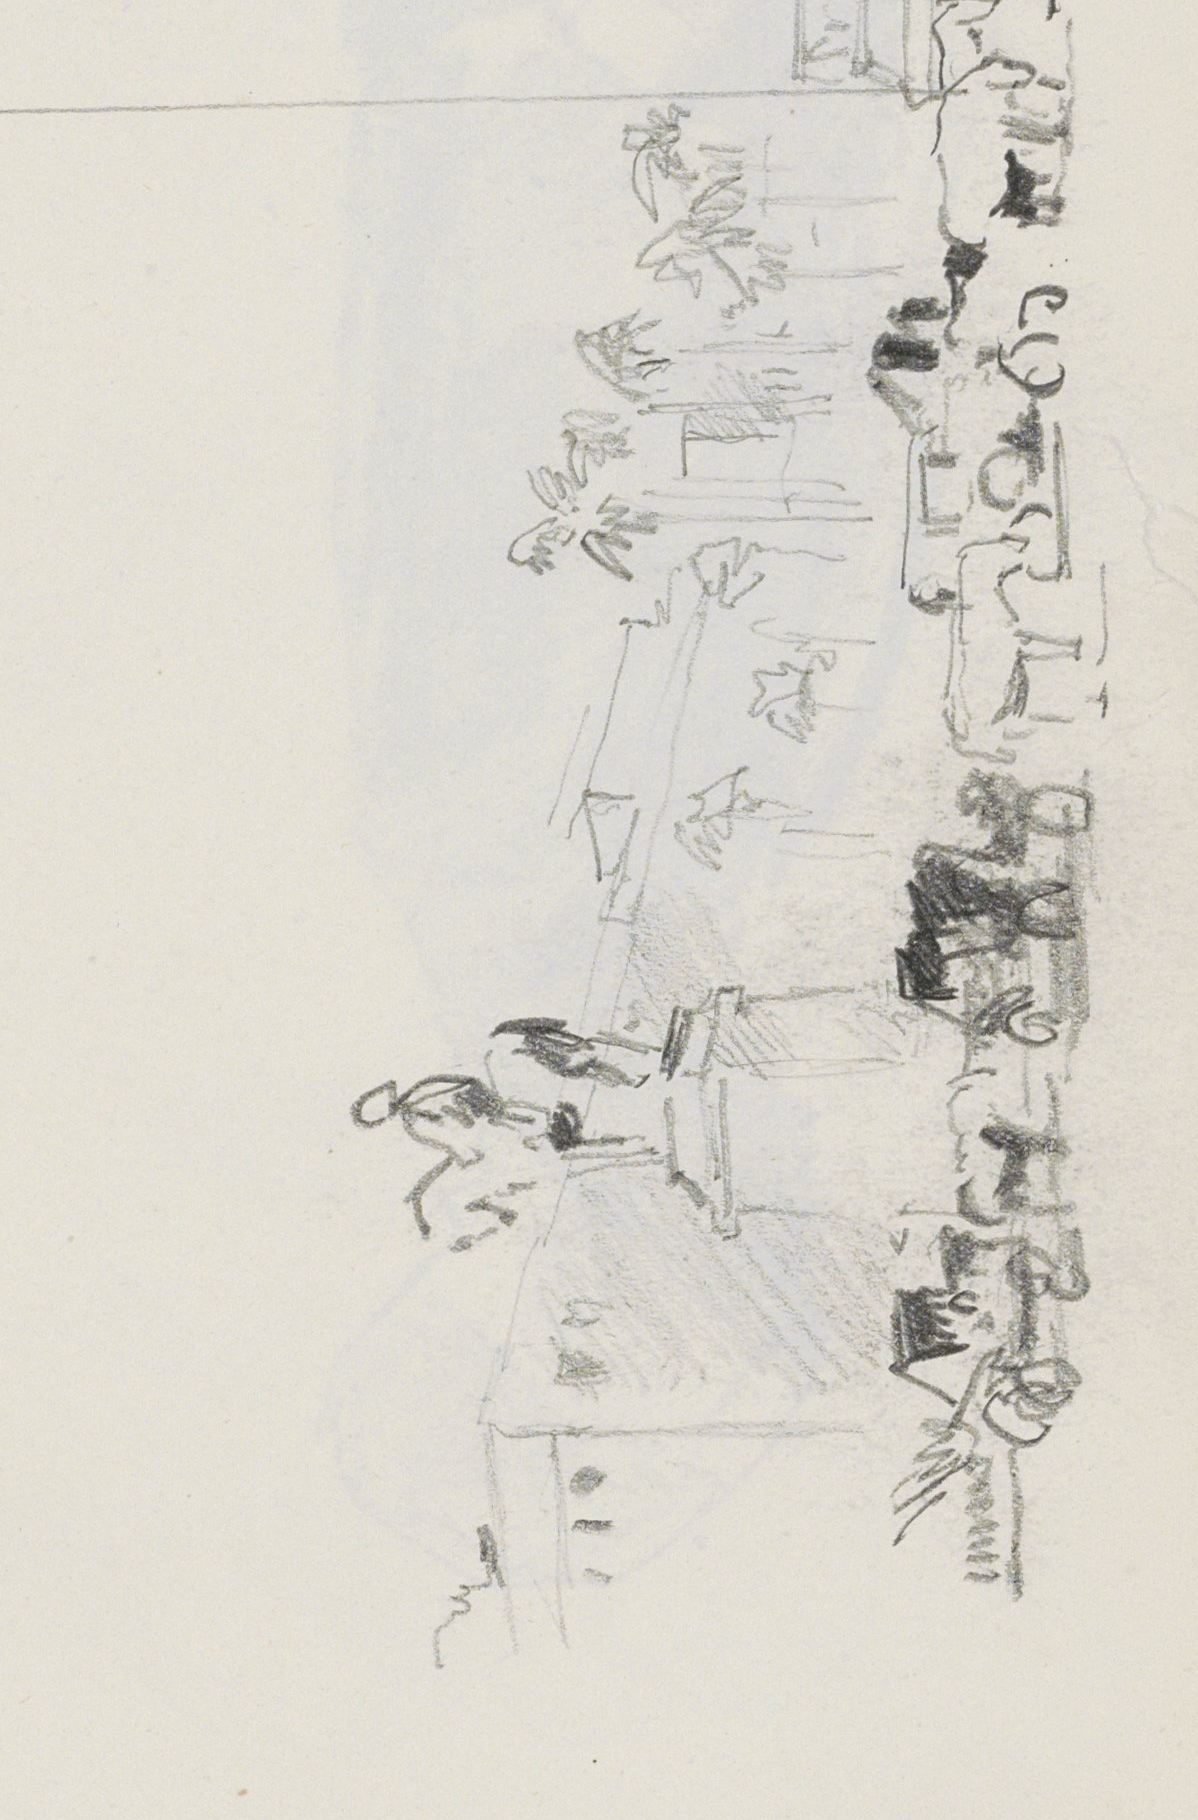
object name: sketchbook leaf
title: Noord-Afrikaanse straat met een ruiterstandbeeld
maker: cornelis vreedenburgh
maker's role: draughtsman, print maker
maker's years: 1880-1946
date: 1936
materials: paper, pencil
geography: maghreb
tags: equestrian statue, street (+ city(-scape) with figures, staffage)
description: Op de straat figuren, paarden en wagens en palmbomen. Blad 30 recto uit een schetsboek met 73 bladen.